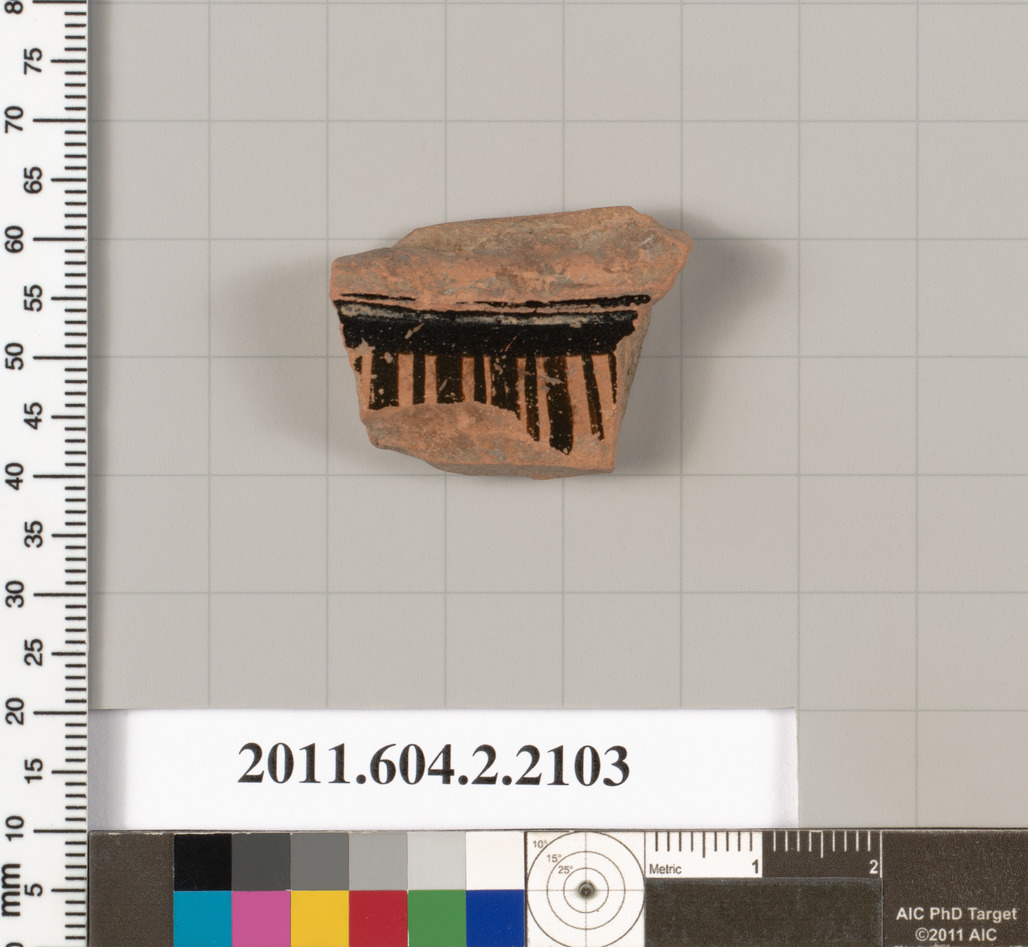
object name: pot fragment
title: Terracotta fragment of a pot; glazed on the inside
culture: greek, attic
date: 475-451 BCE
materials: terracotta